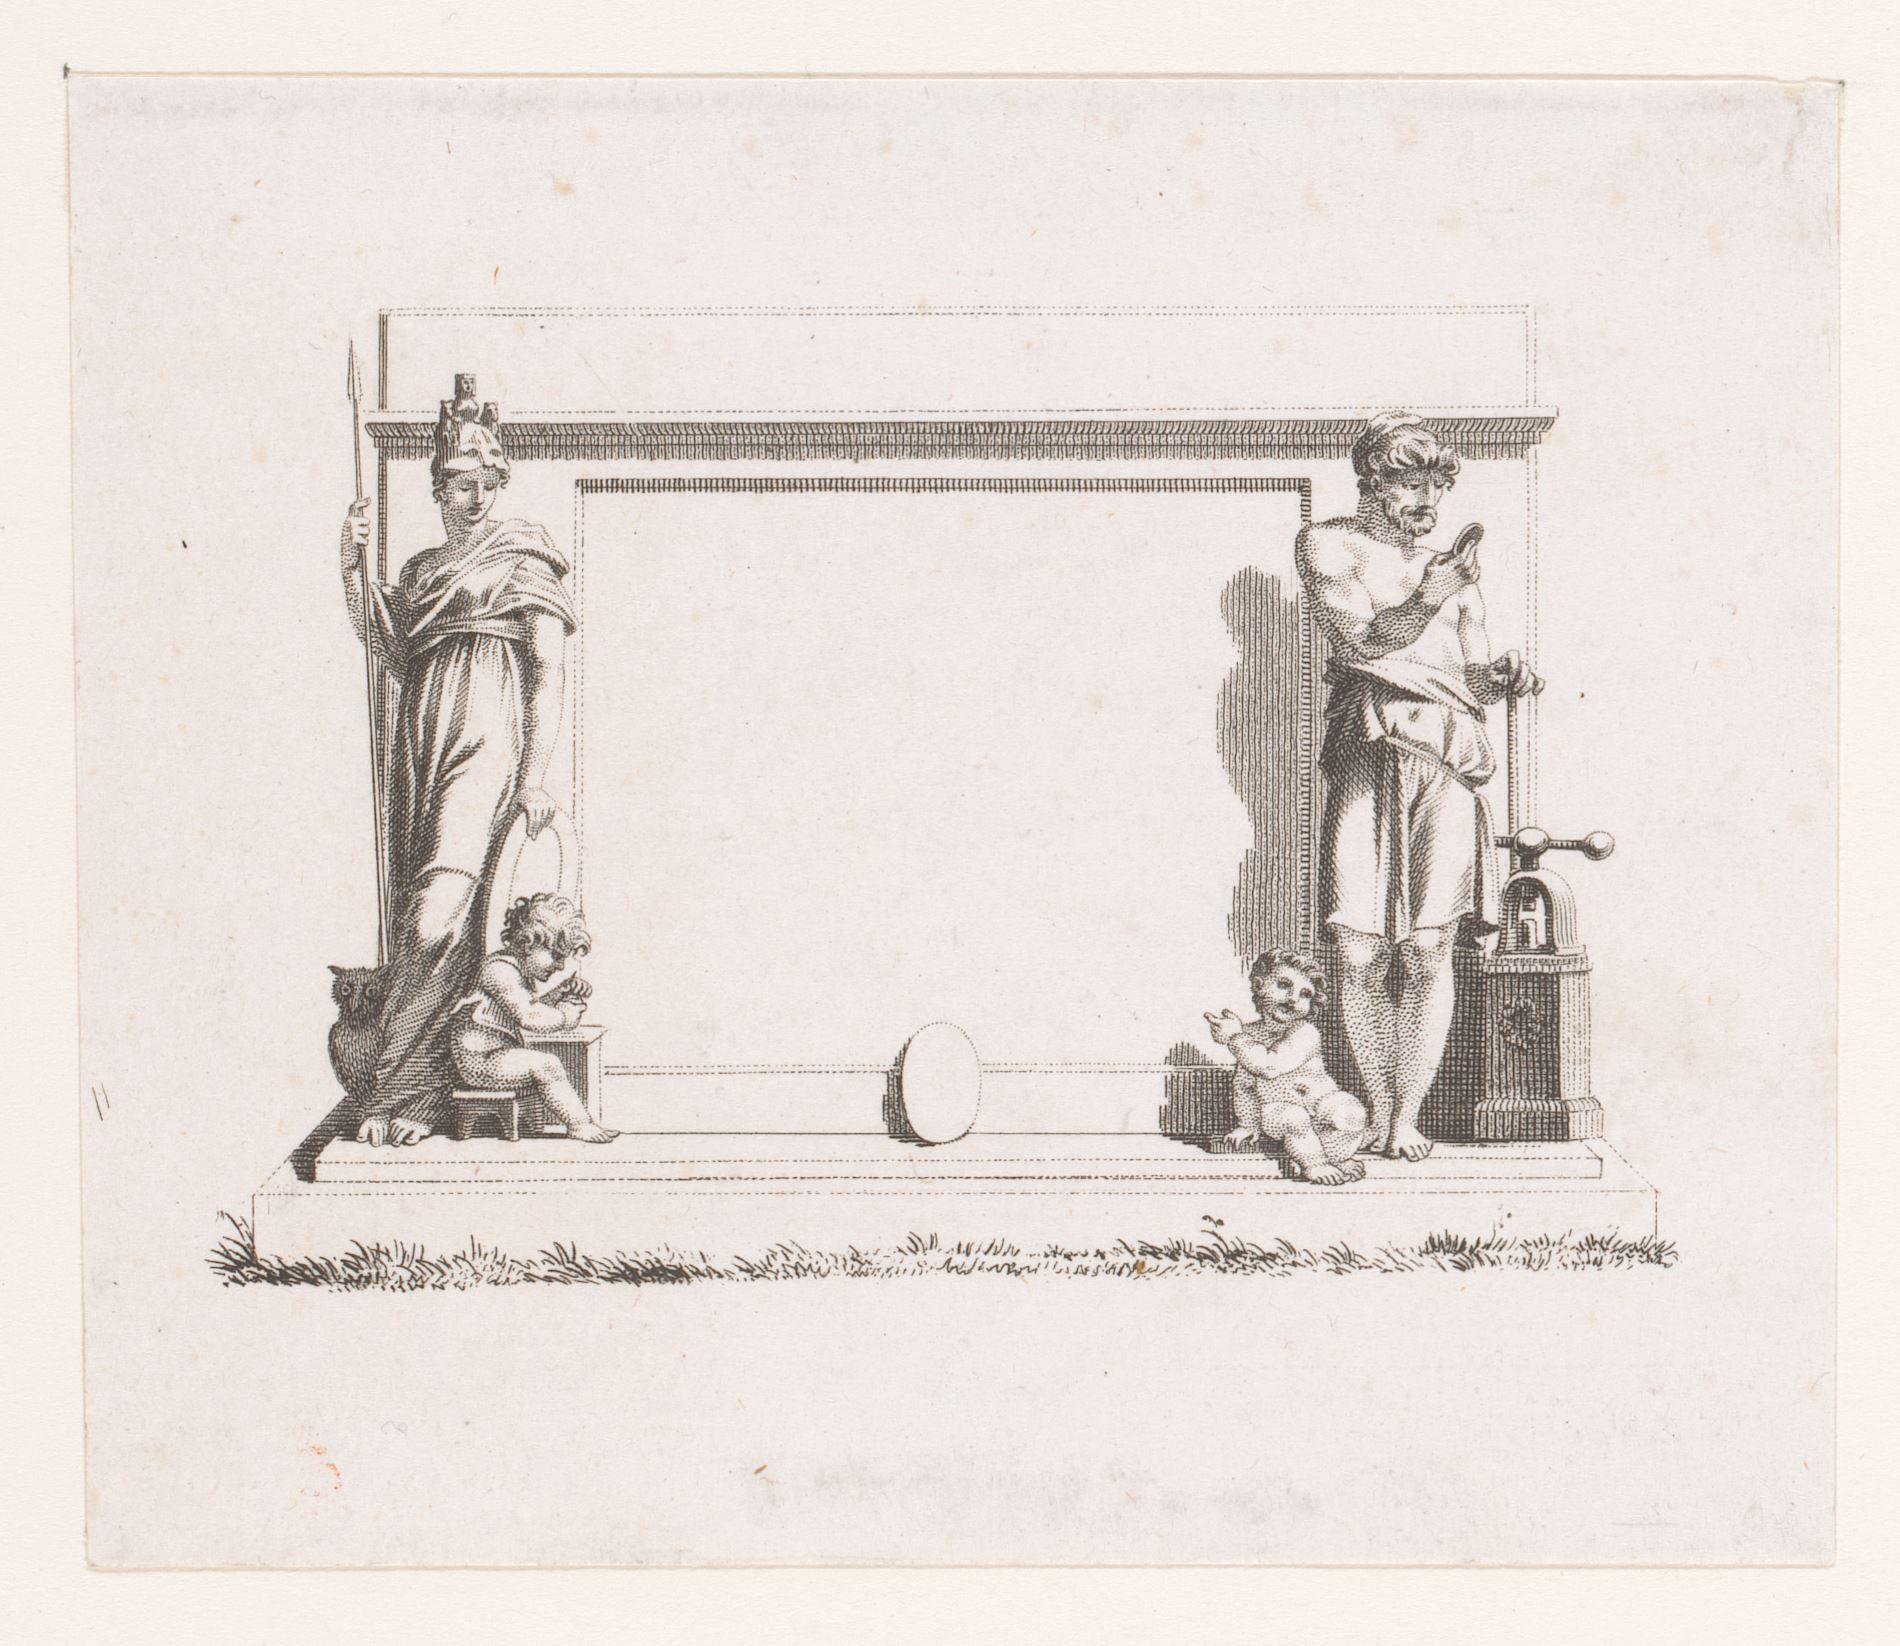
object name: print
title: Merlen/ graveur sur tous Métaux/ & sur Pierres fines (...)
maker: barthélémy joseph fulcran roger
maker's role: print maker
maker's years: 1767-1841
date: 1779-1850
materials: paper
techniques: etching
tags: jean baptiste merlen, (story of) vulcan (hephaestus), (story of) minerva (pallas, athena), printing press, medal (considered as a piece of sculpture, regardless of its specific function), engraving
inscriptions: collector's mark: Lugt 2228